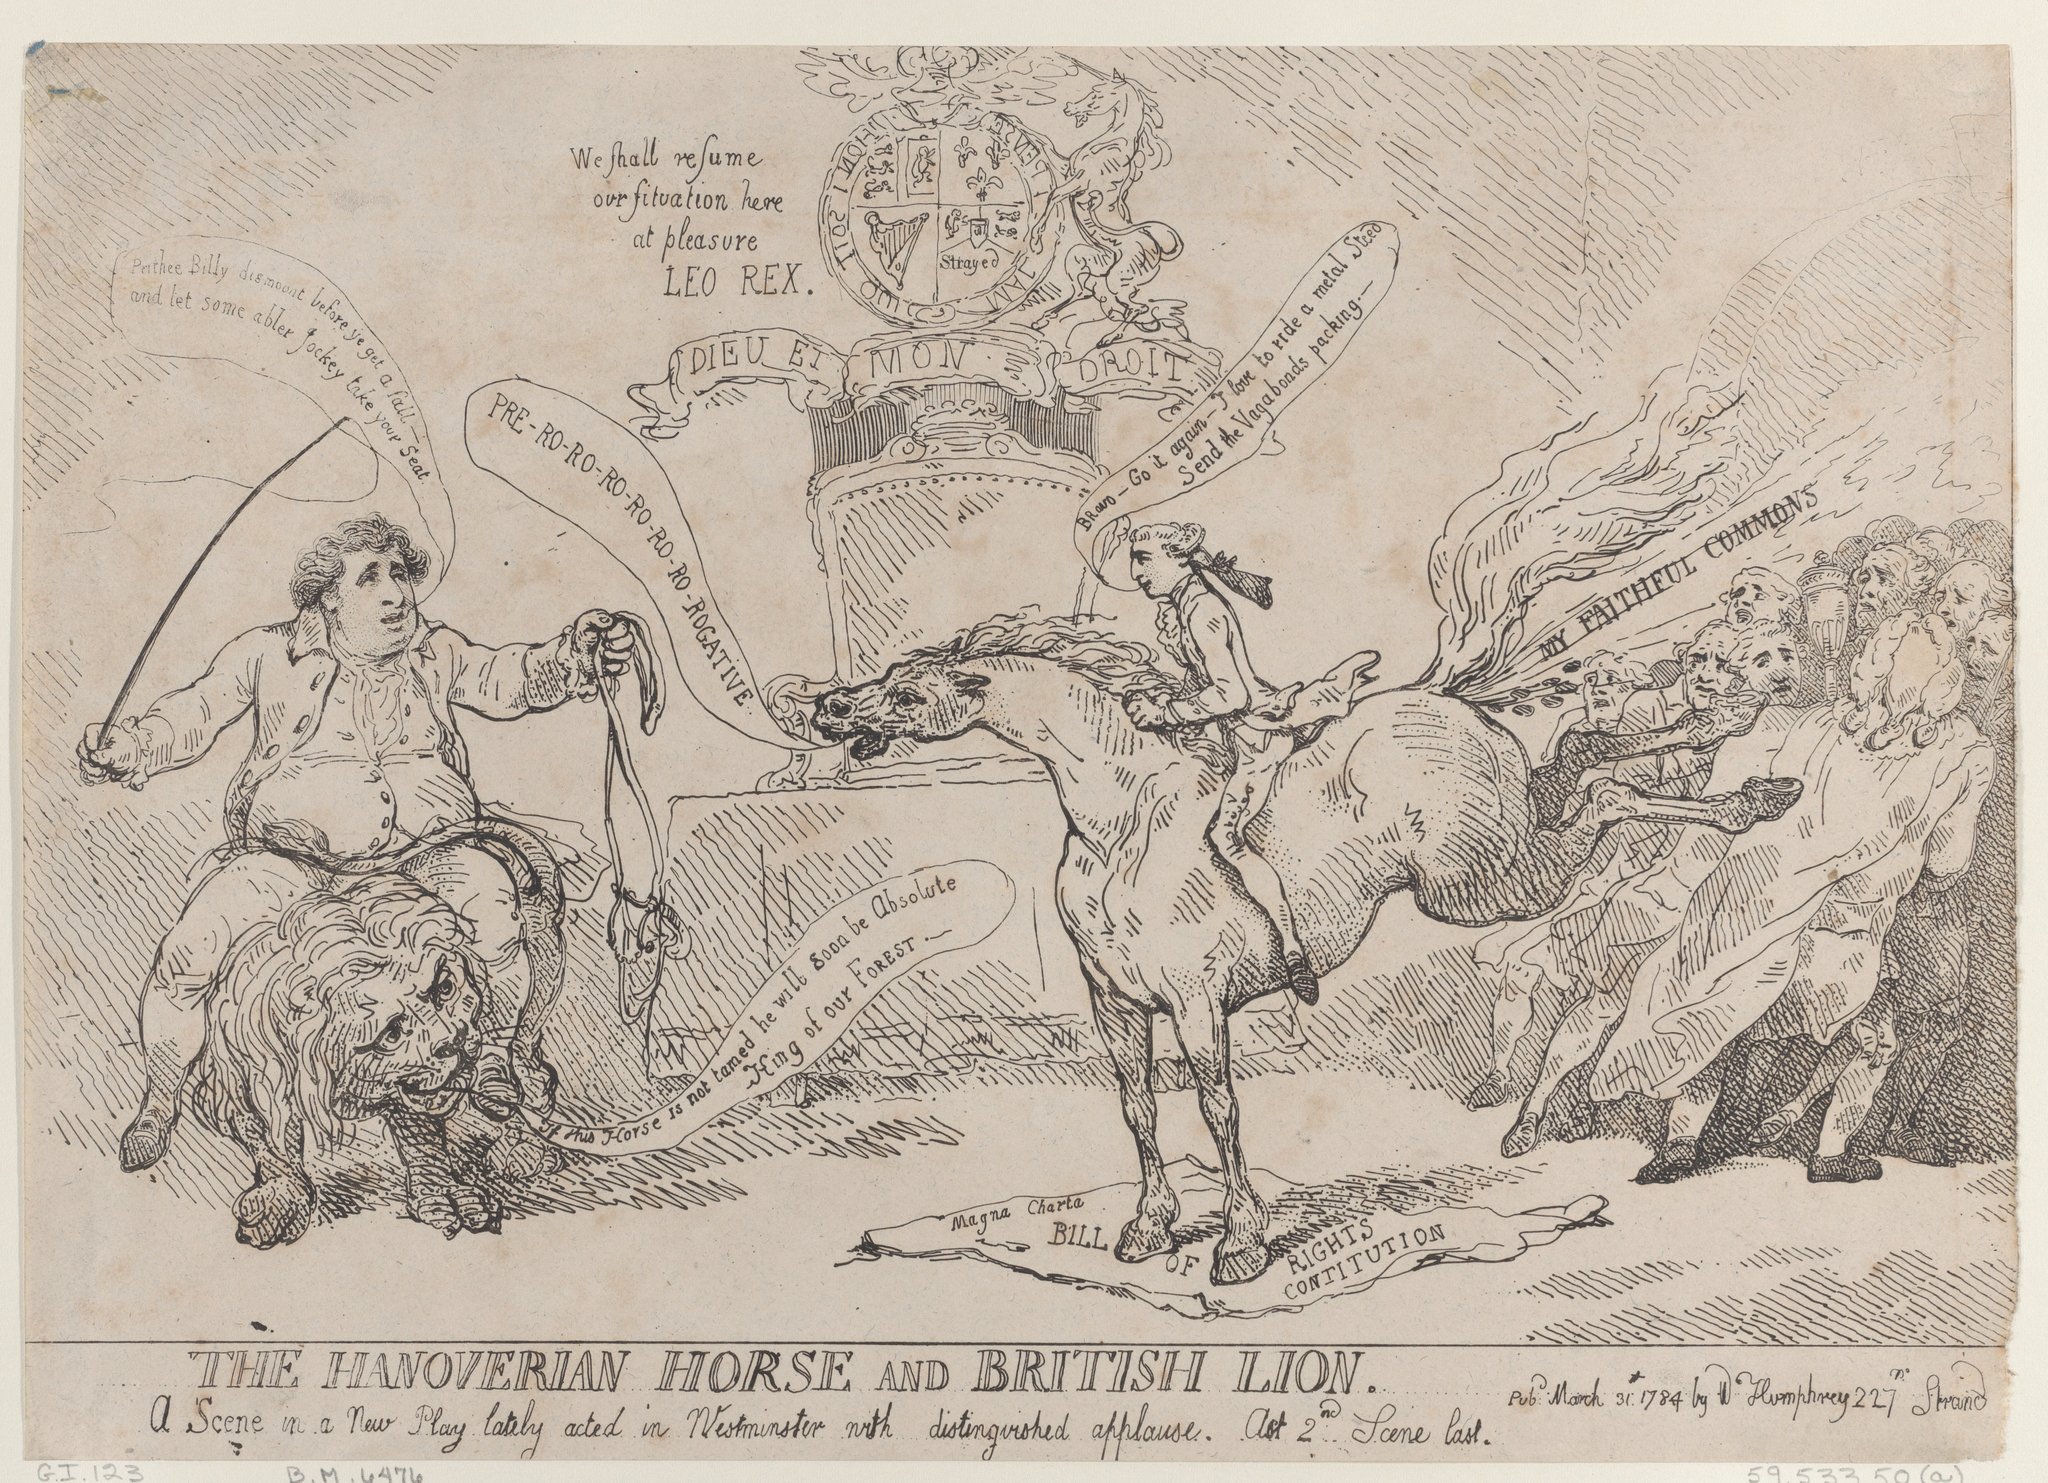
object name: print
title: The Hanoverian Horse and British Lion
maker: thomas rowlandson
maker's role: artist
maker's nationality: british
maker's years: 1757-1827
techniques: etching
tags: satire,men,horses,lions,politics